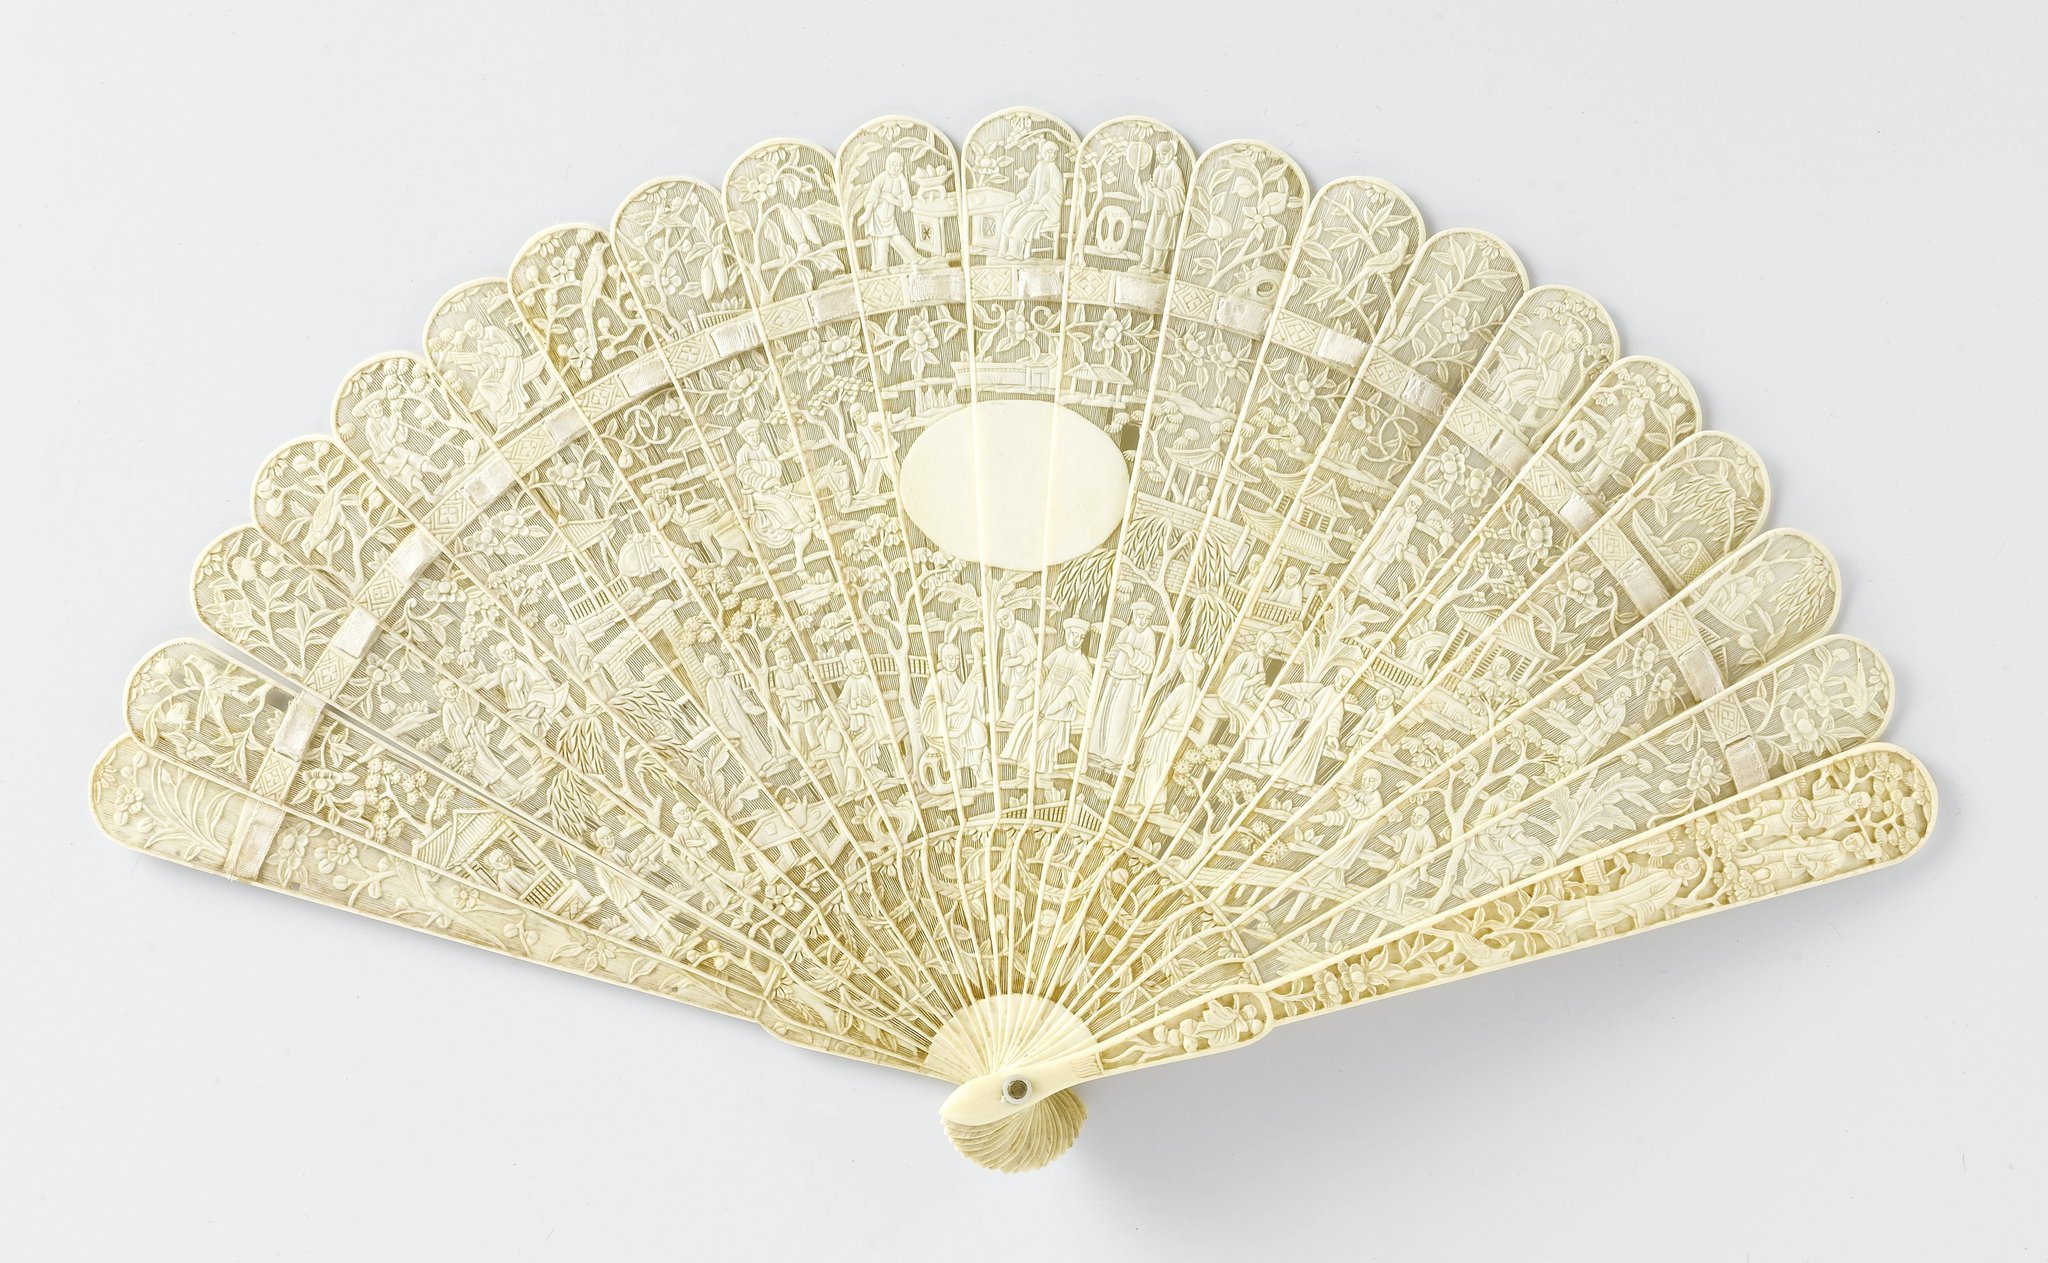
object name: brisé fan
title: Brisé-waaier van ajour en in reliëf gesneden ivoor waarop scènes uit het Chinese leven met pagodes, huizen, bomen en in het midden een onversierd ovaal medaillon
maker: Anonymous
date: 1800-1820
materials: copper, ivory, mother of pearl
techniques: cutting, embroidery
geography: guangdong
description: Brisé-waaier van ajour en in reliëf gesneden ivoor waarop scènes uit het Chinezen leven met pagodes, huizen, bomen en in het midden een onversierd ovaal medaillon. Model: 21 aaneengesloten benen. Sluitpin van koper omgeven door parelmoeren schijfje. Versiering: onder het ovale medaillon bevindt zich vrij centraal een zittende man met links van hem een musicerende zittende vrouw. Beide zijn omgeven door staande figuren en bomen. Rechts op de achtergrond een pagode. De benen zijn tot aan het waaierlint gevuld met scènes uit het Chinese leven, zowel binnen als buiten. De geschulpte rand boven het waaierlint is afwisselend gevuld met figuren, vogels, blad- en bloemmotieven en rechts een sampan (gedeeltelijk overdekte Aziatische boot).